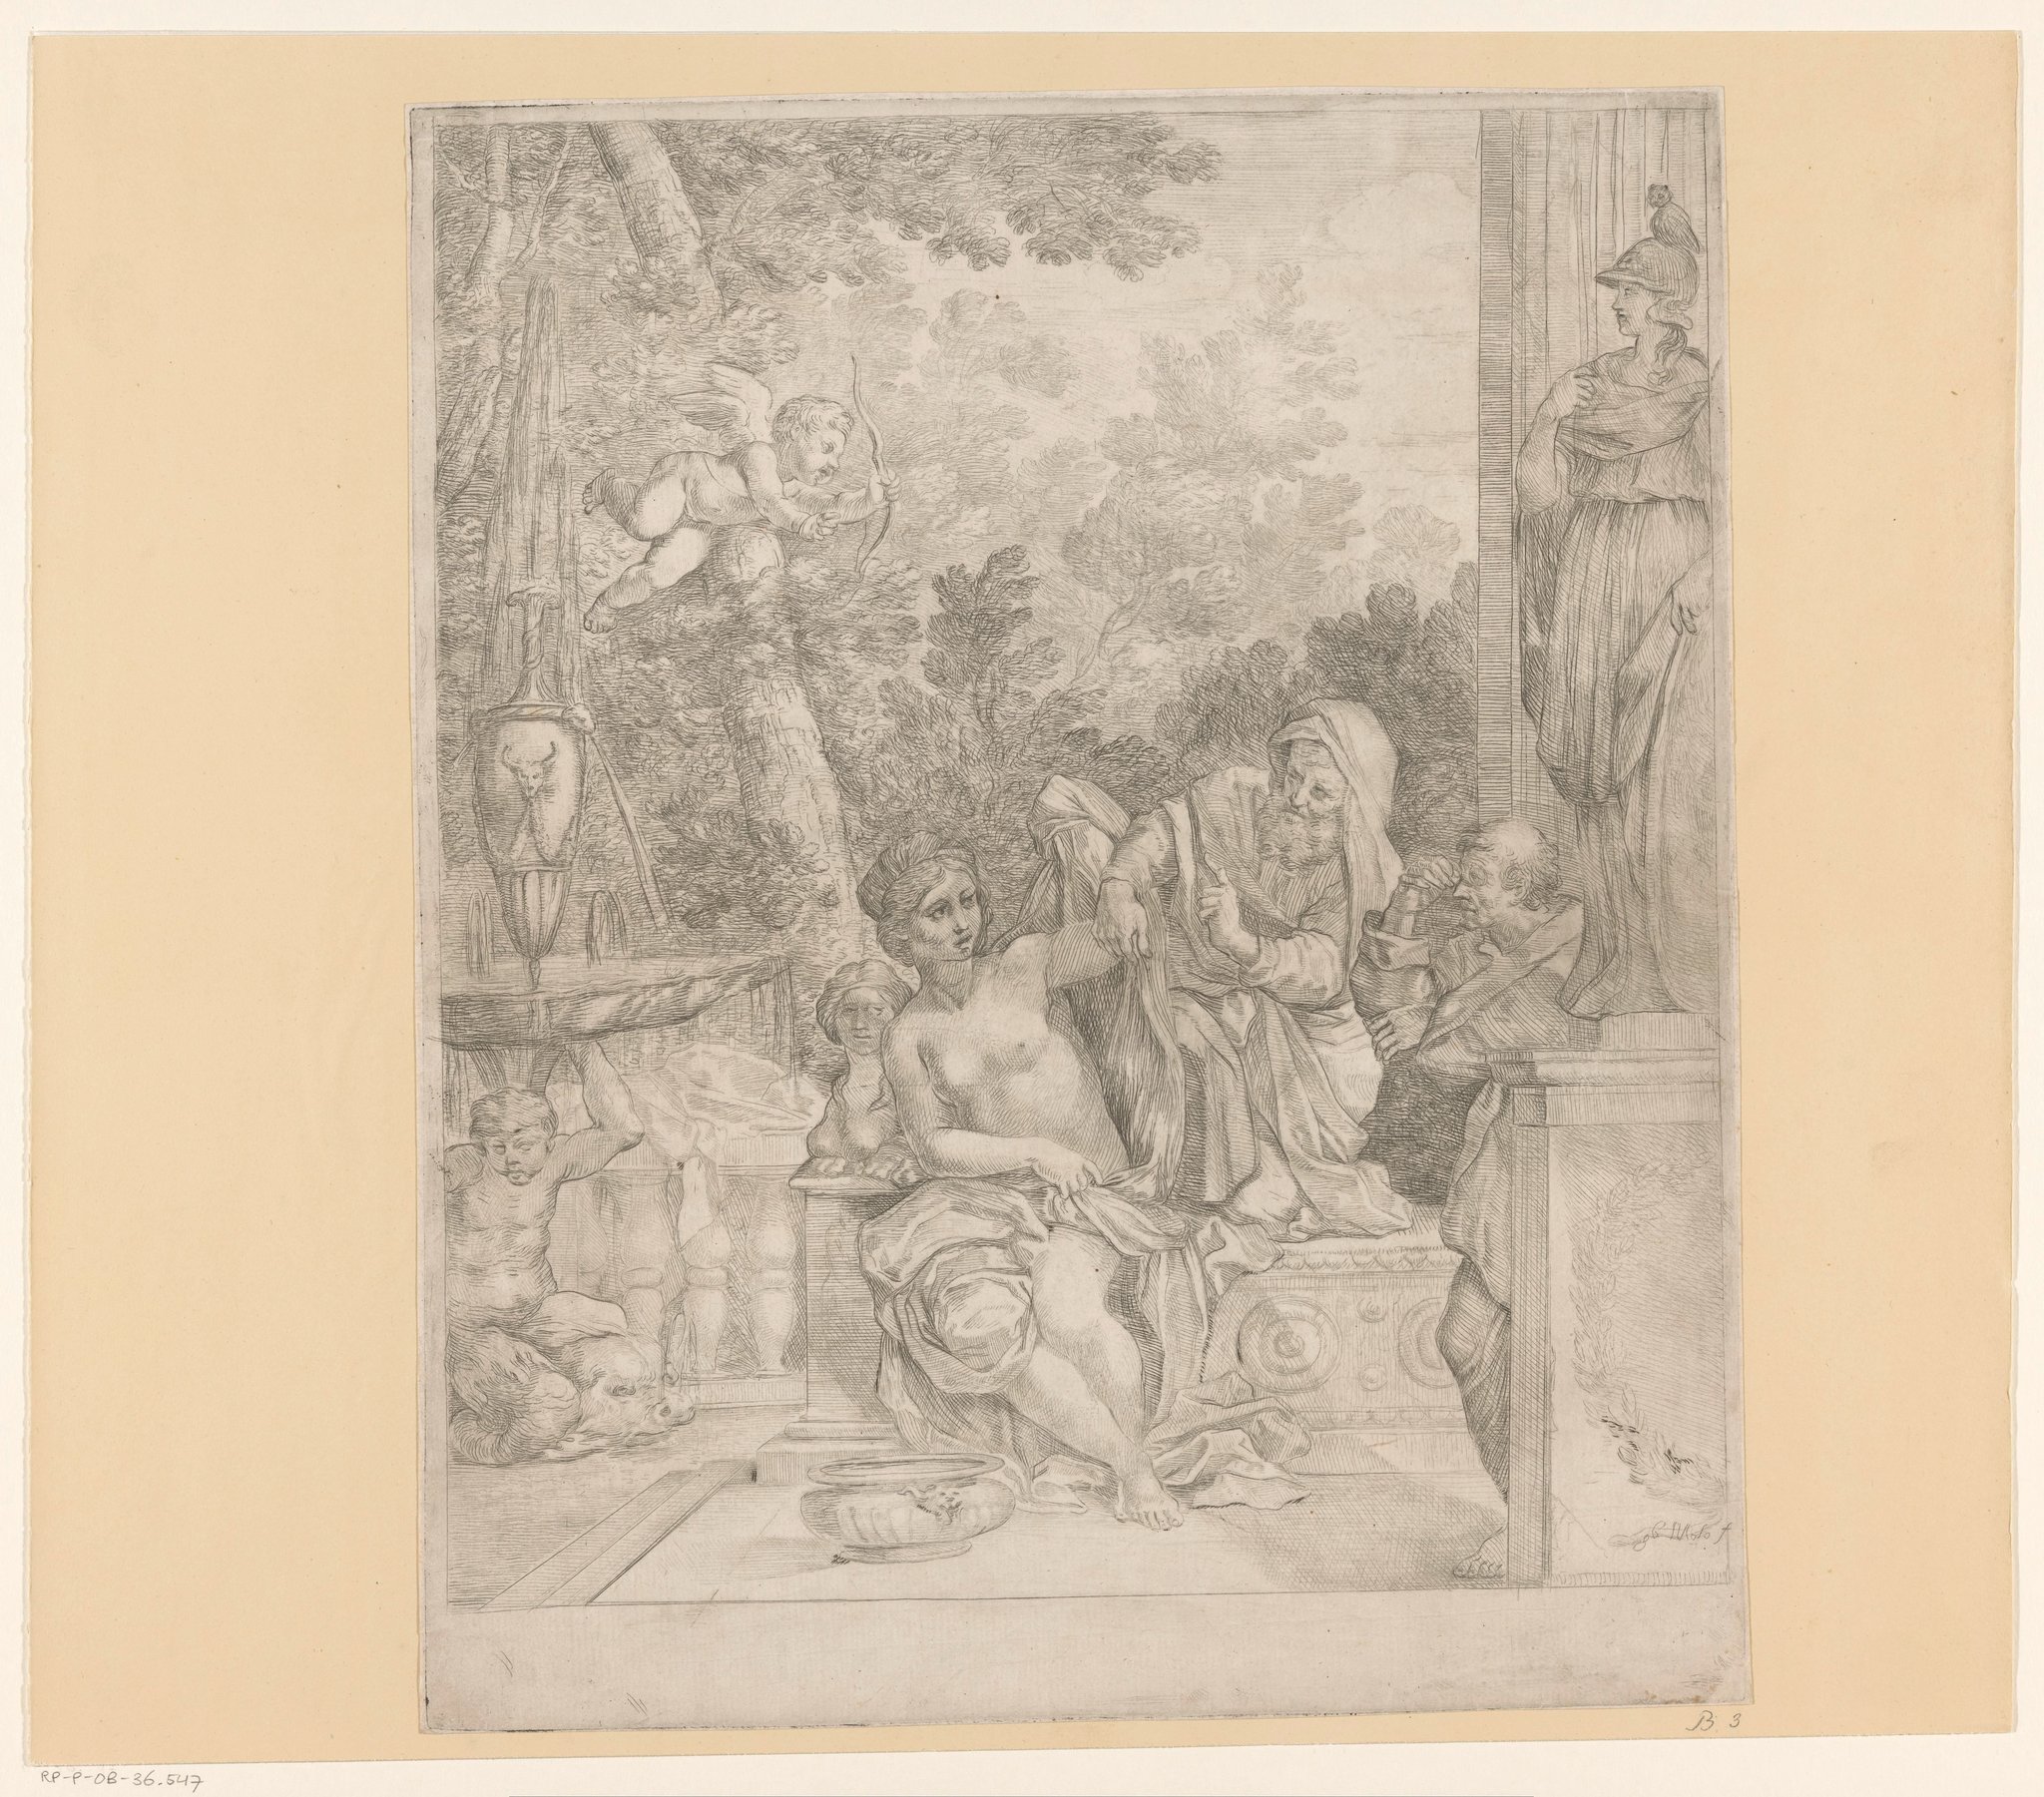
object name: print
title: Susanna en de ouderlingen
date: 1598-1665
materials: paper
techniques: etching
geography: italy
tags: susanna bathing, usually in or near a fountain and sometimes accompanied by two female servants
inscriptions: collector's mark: Lugt 240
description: Susanna zittend bij een fontein. Zij wordt vastgegrepen door twee oude mannen die dreigen haar aan te geven op beschuldiging van overspel indien zij zich tegen hen verzet.